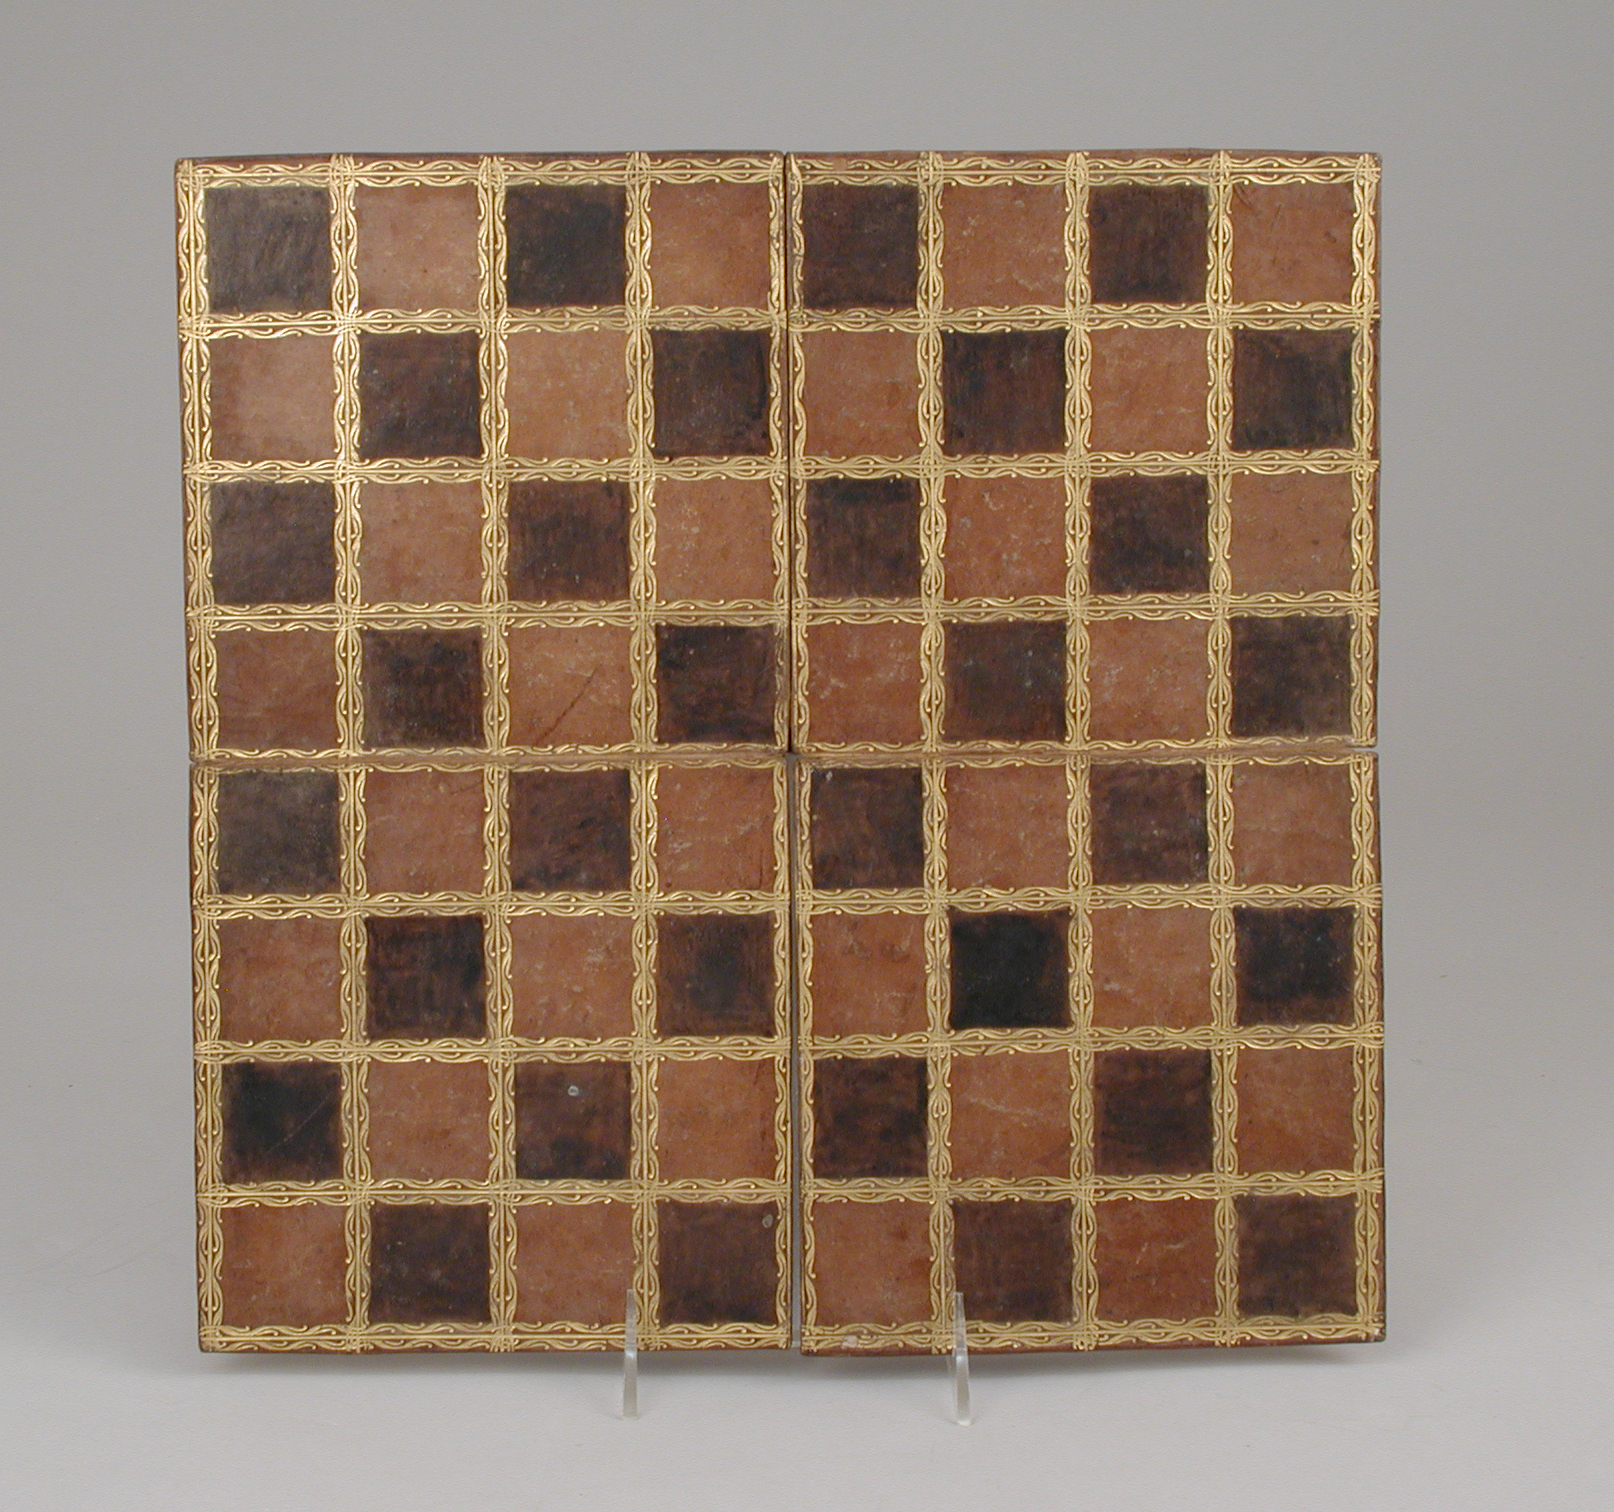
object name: chessboard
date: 1767-1800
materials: gold, leather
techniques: tooling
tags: chess